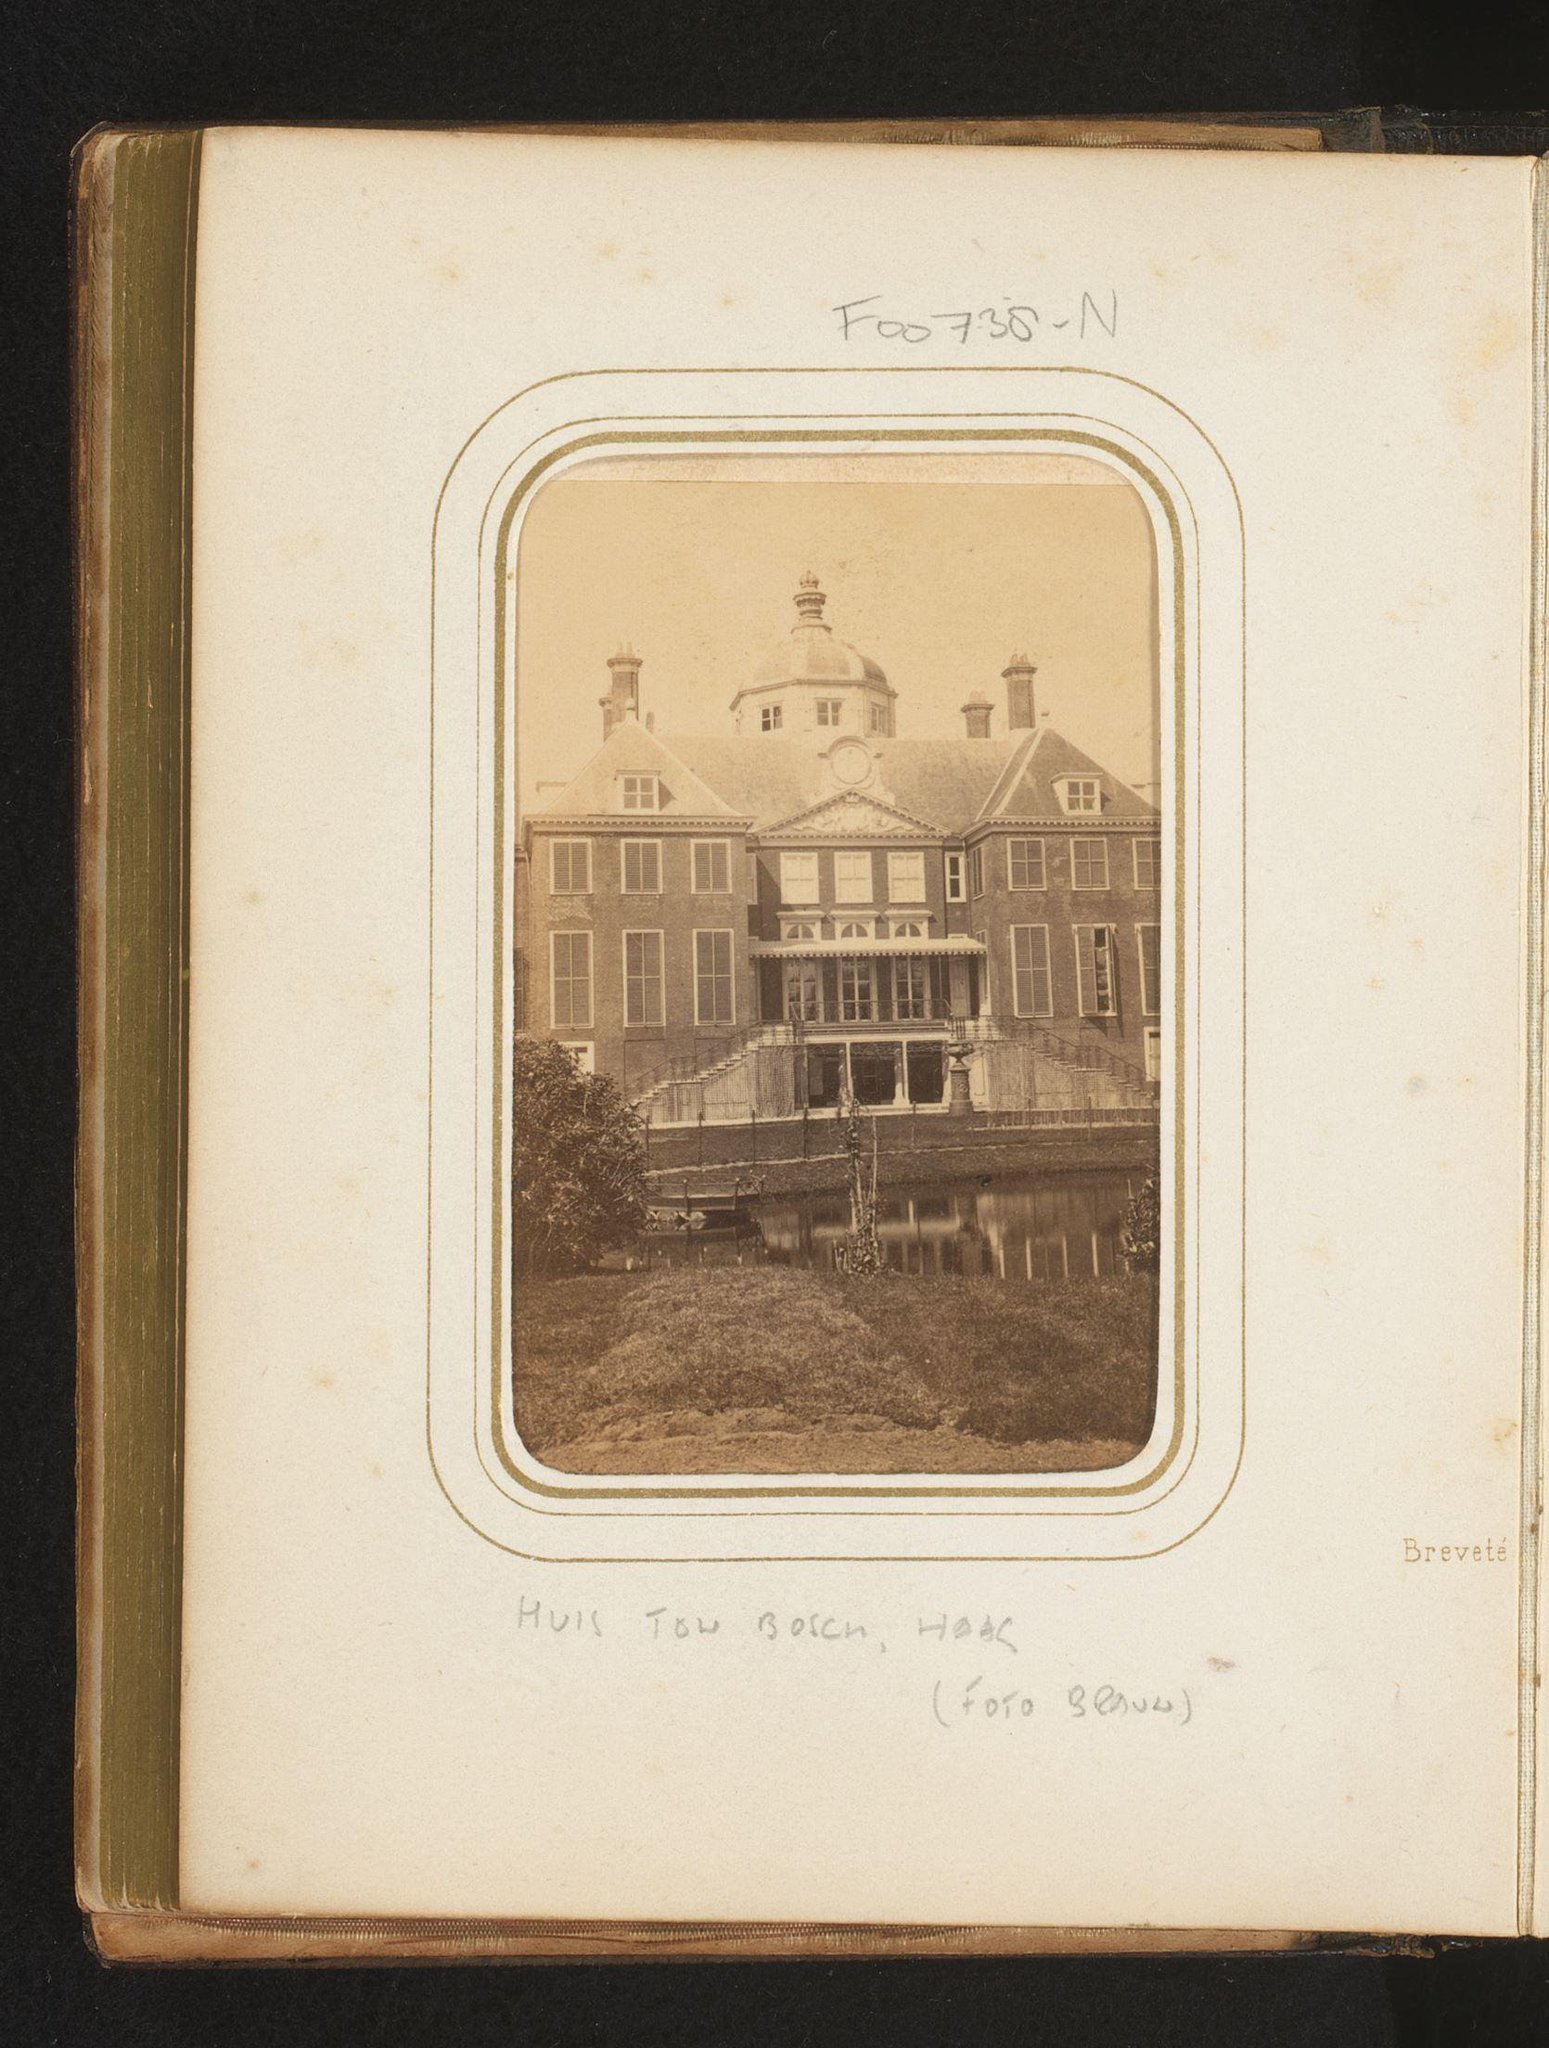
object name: album leaf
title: Gezicht op Paleis Huis ten Bosch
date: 1850-1877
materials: cardboard, photographic support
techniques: albumen print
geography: the hague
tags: palace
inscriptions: annotation: ‘Huis Ten Bosch, Haag/ (Foto Braun)’, inscription: ‘Breveté S.G.D.G.’, inscription: ‘Ad. Braun/ PHOTOGRAPHE/ A DORNACH/ (Ht Rhin)’, inscription: ‘No 3864. La Haye./ Le château du bois ('t huis in 't bosch).’